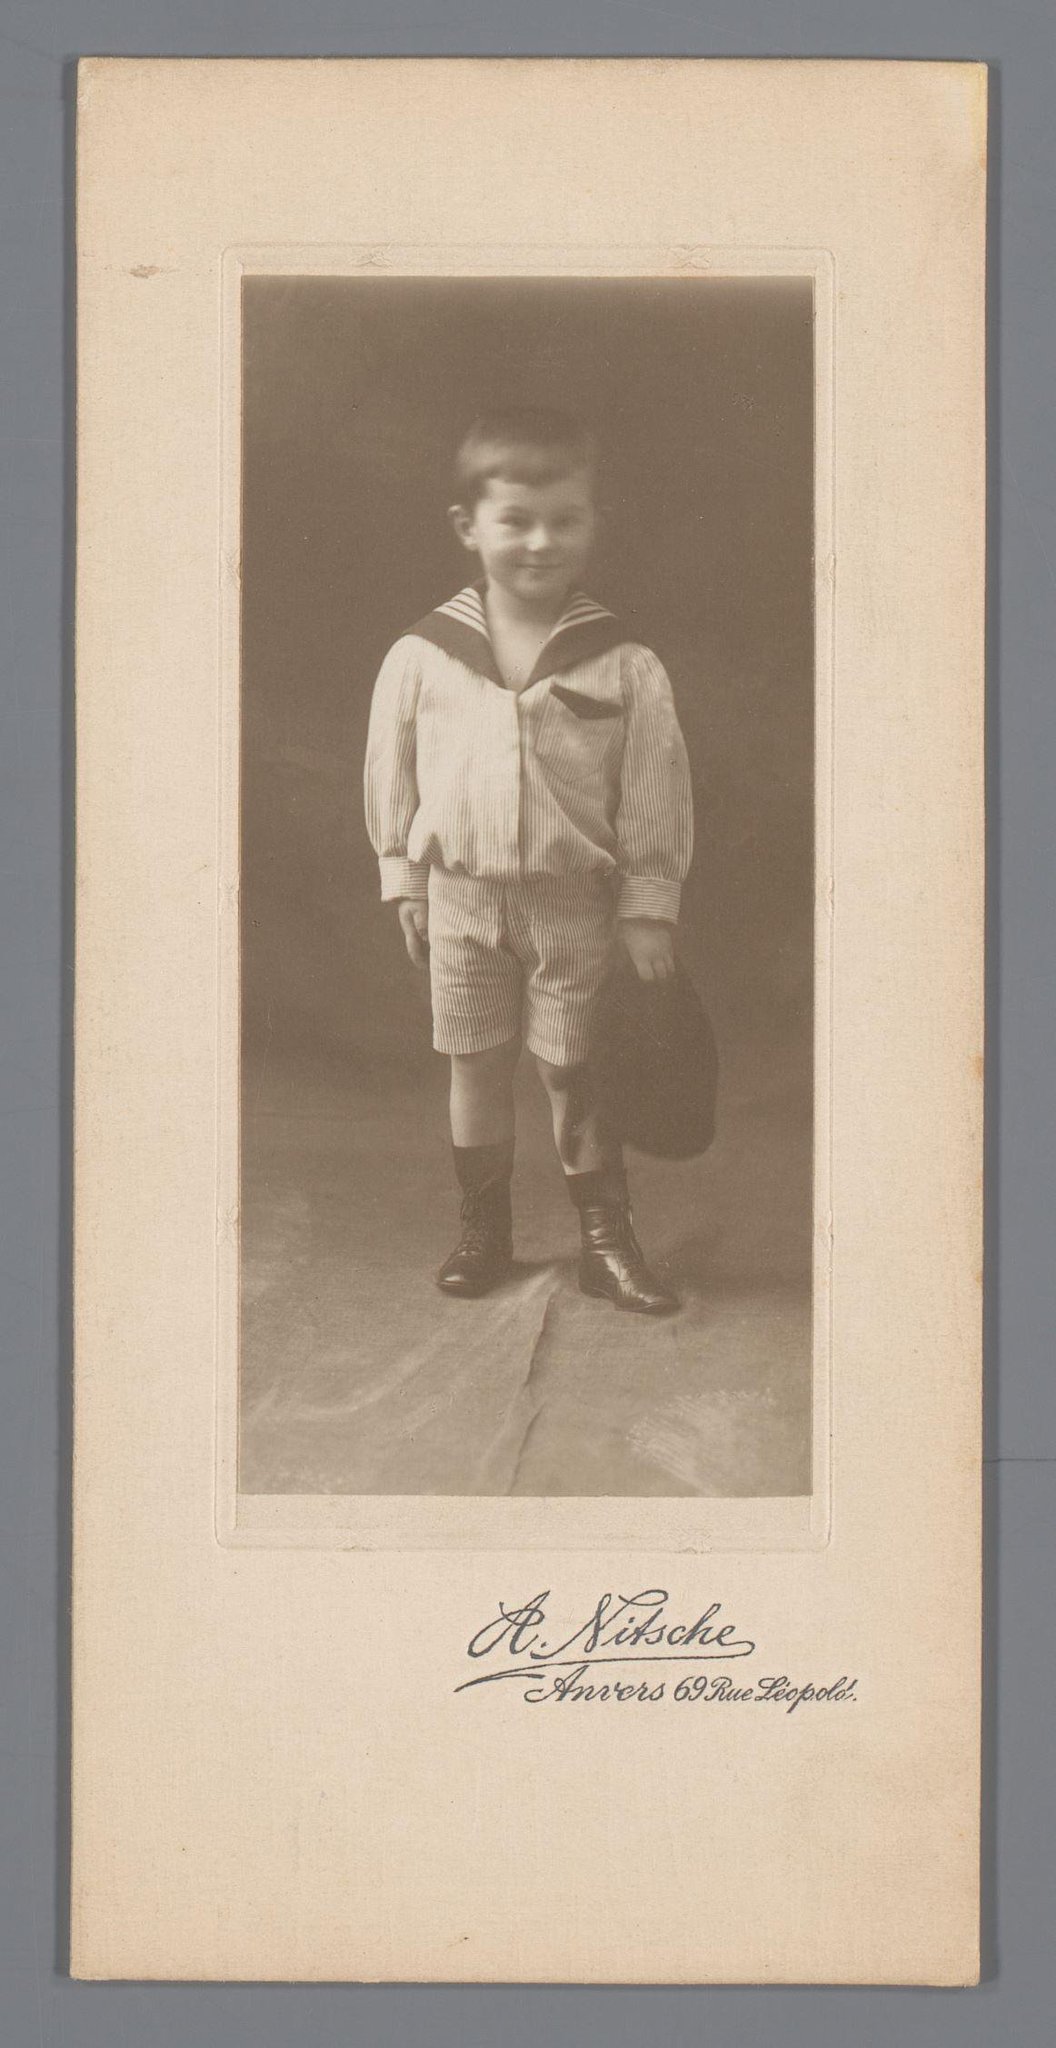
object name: photograph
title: Portret van een staande jongen in matrozenpak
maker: adolf nitsche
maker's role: fotograaf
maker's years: 1873-1938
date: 1890-1910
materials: cardboard, paper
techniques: albumen print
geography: antwerp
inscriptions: inscription: ‘A. Nitsche//Anvers 69 Rue Léopold.’, number: ‘7081’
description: Portret van een staande jongen in matrozenpak.